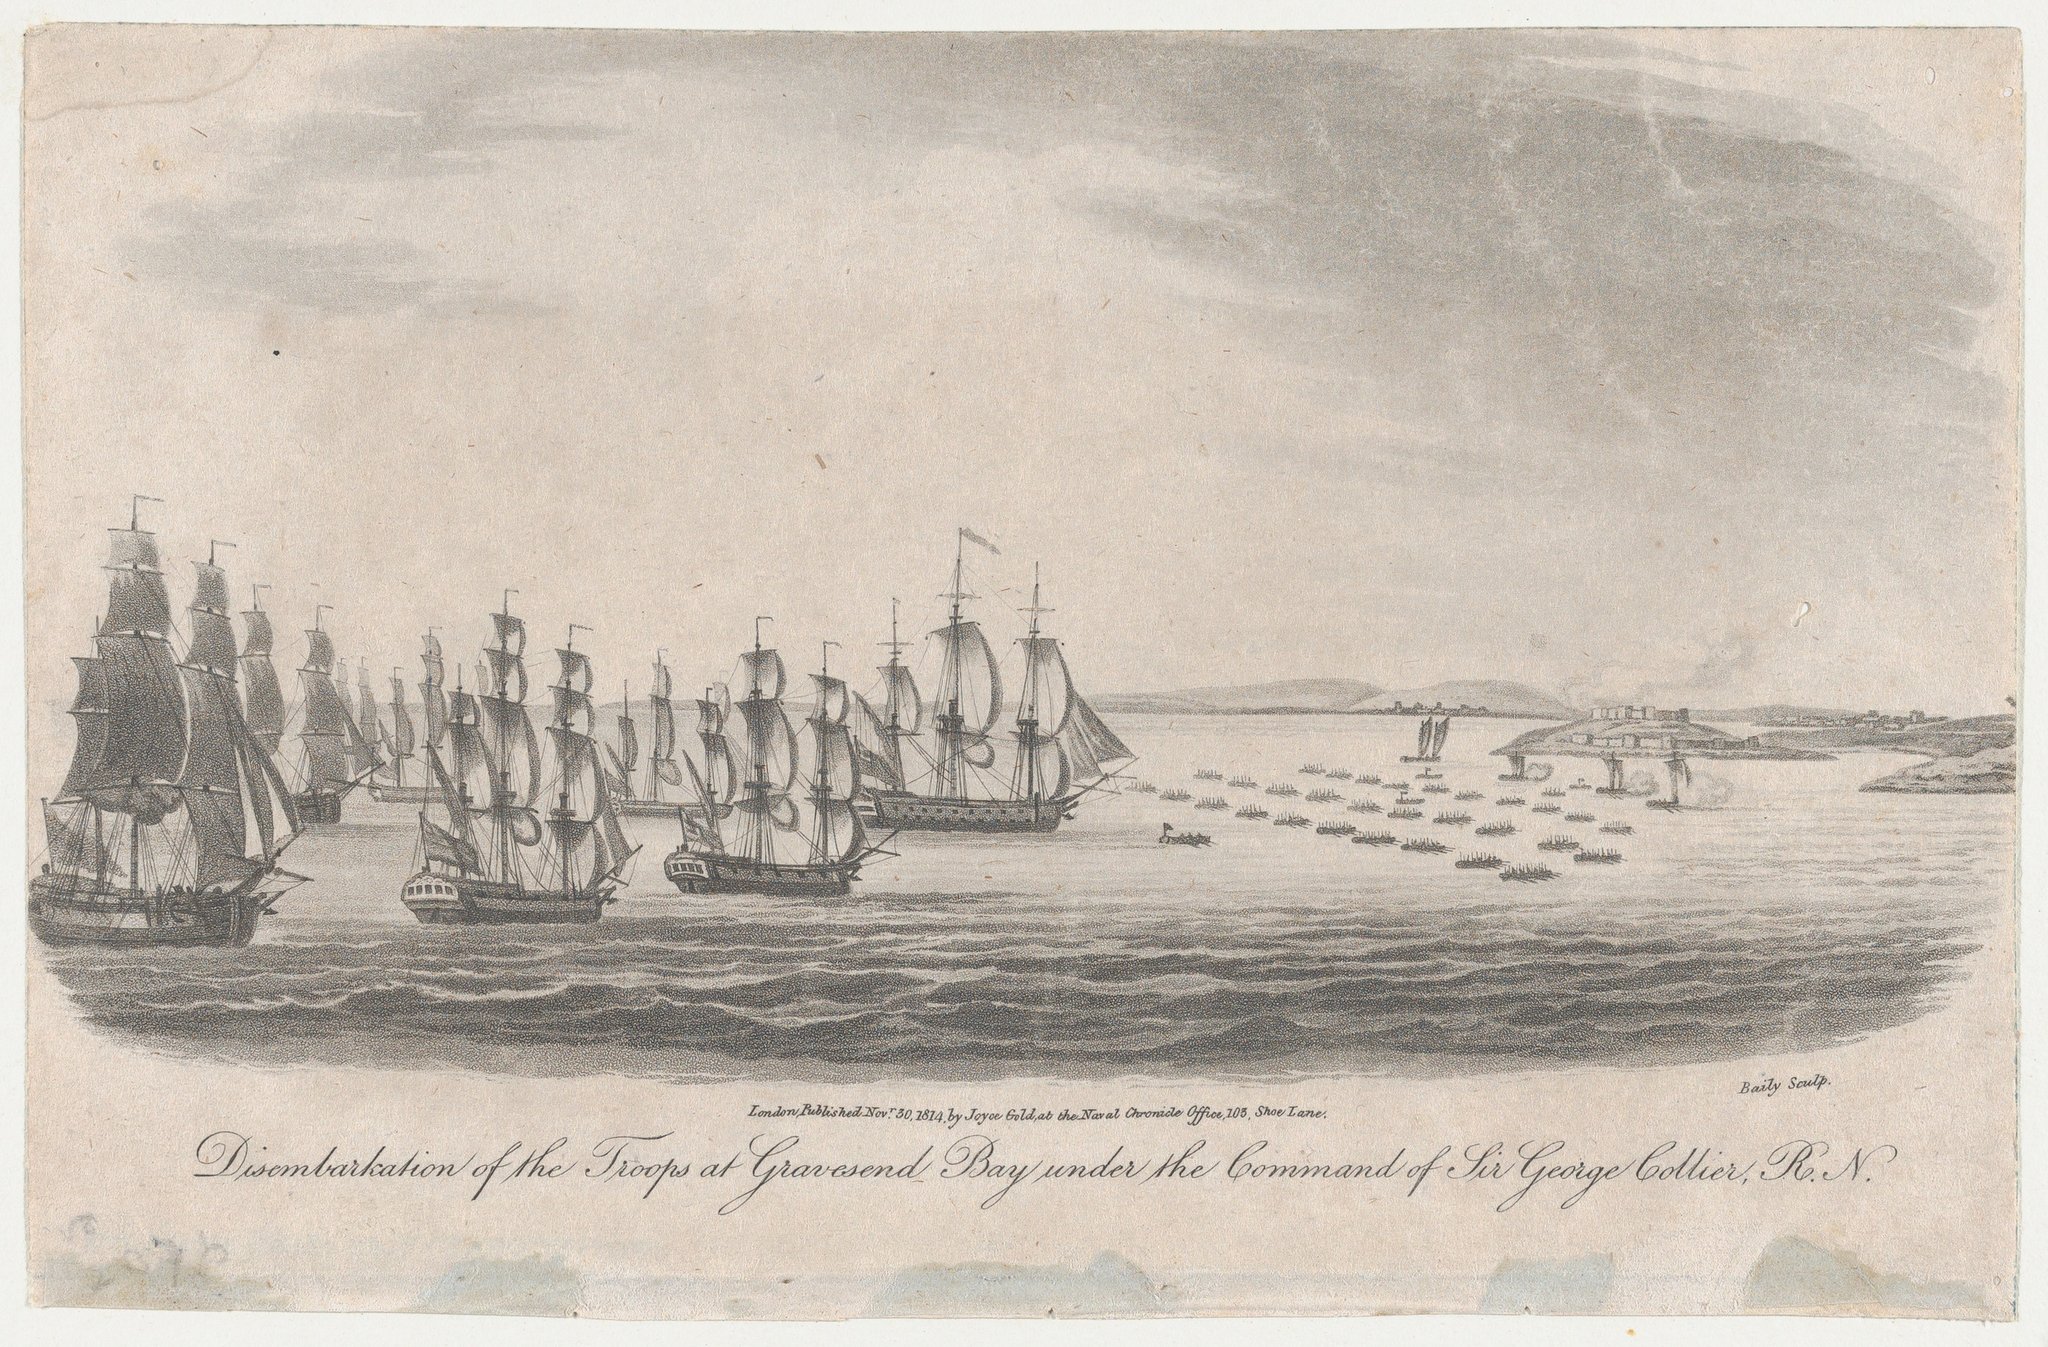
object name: print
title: Disembarkation of the Troops at Gravesend Bay under the Command of General Collier, R.N. (August 22, 1776)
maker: john baily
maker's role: artist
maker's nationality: british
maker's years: 1798-1820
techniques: aquatint, etching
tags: american revolution,boats,ships